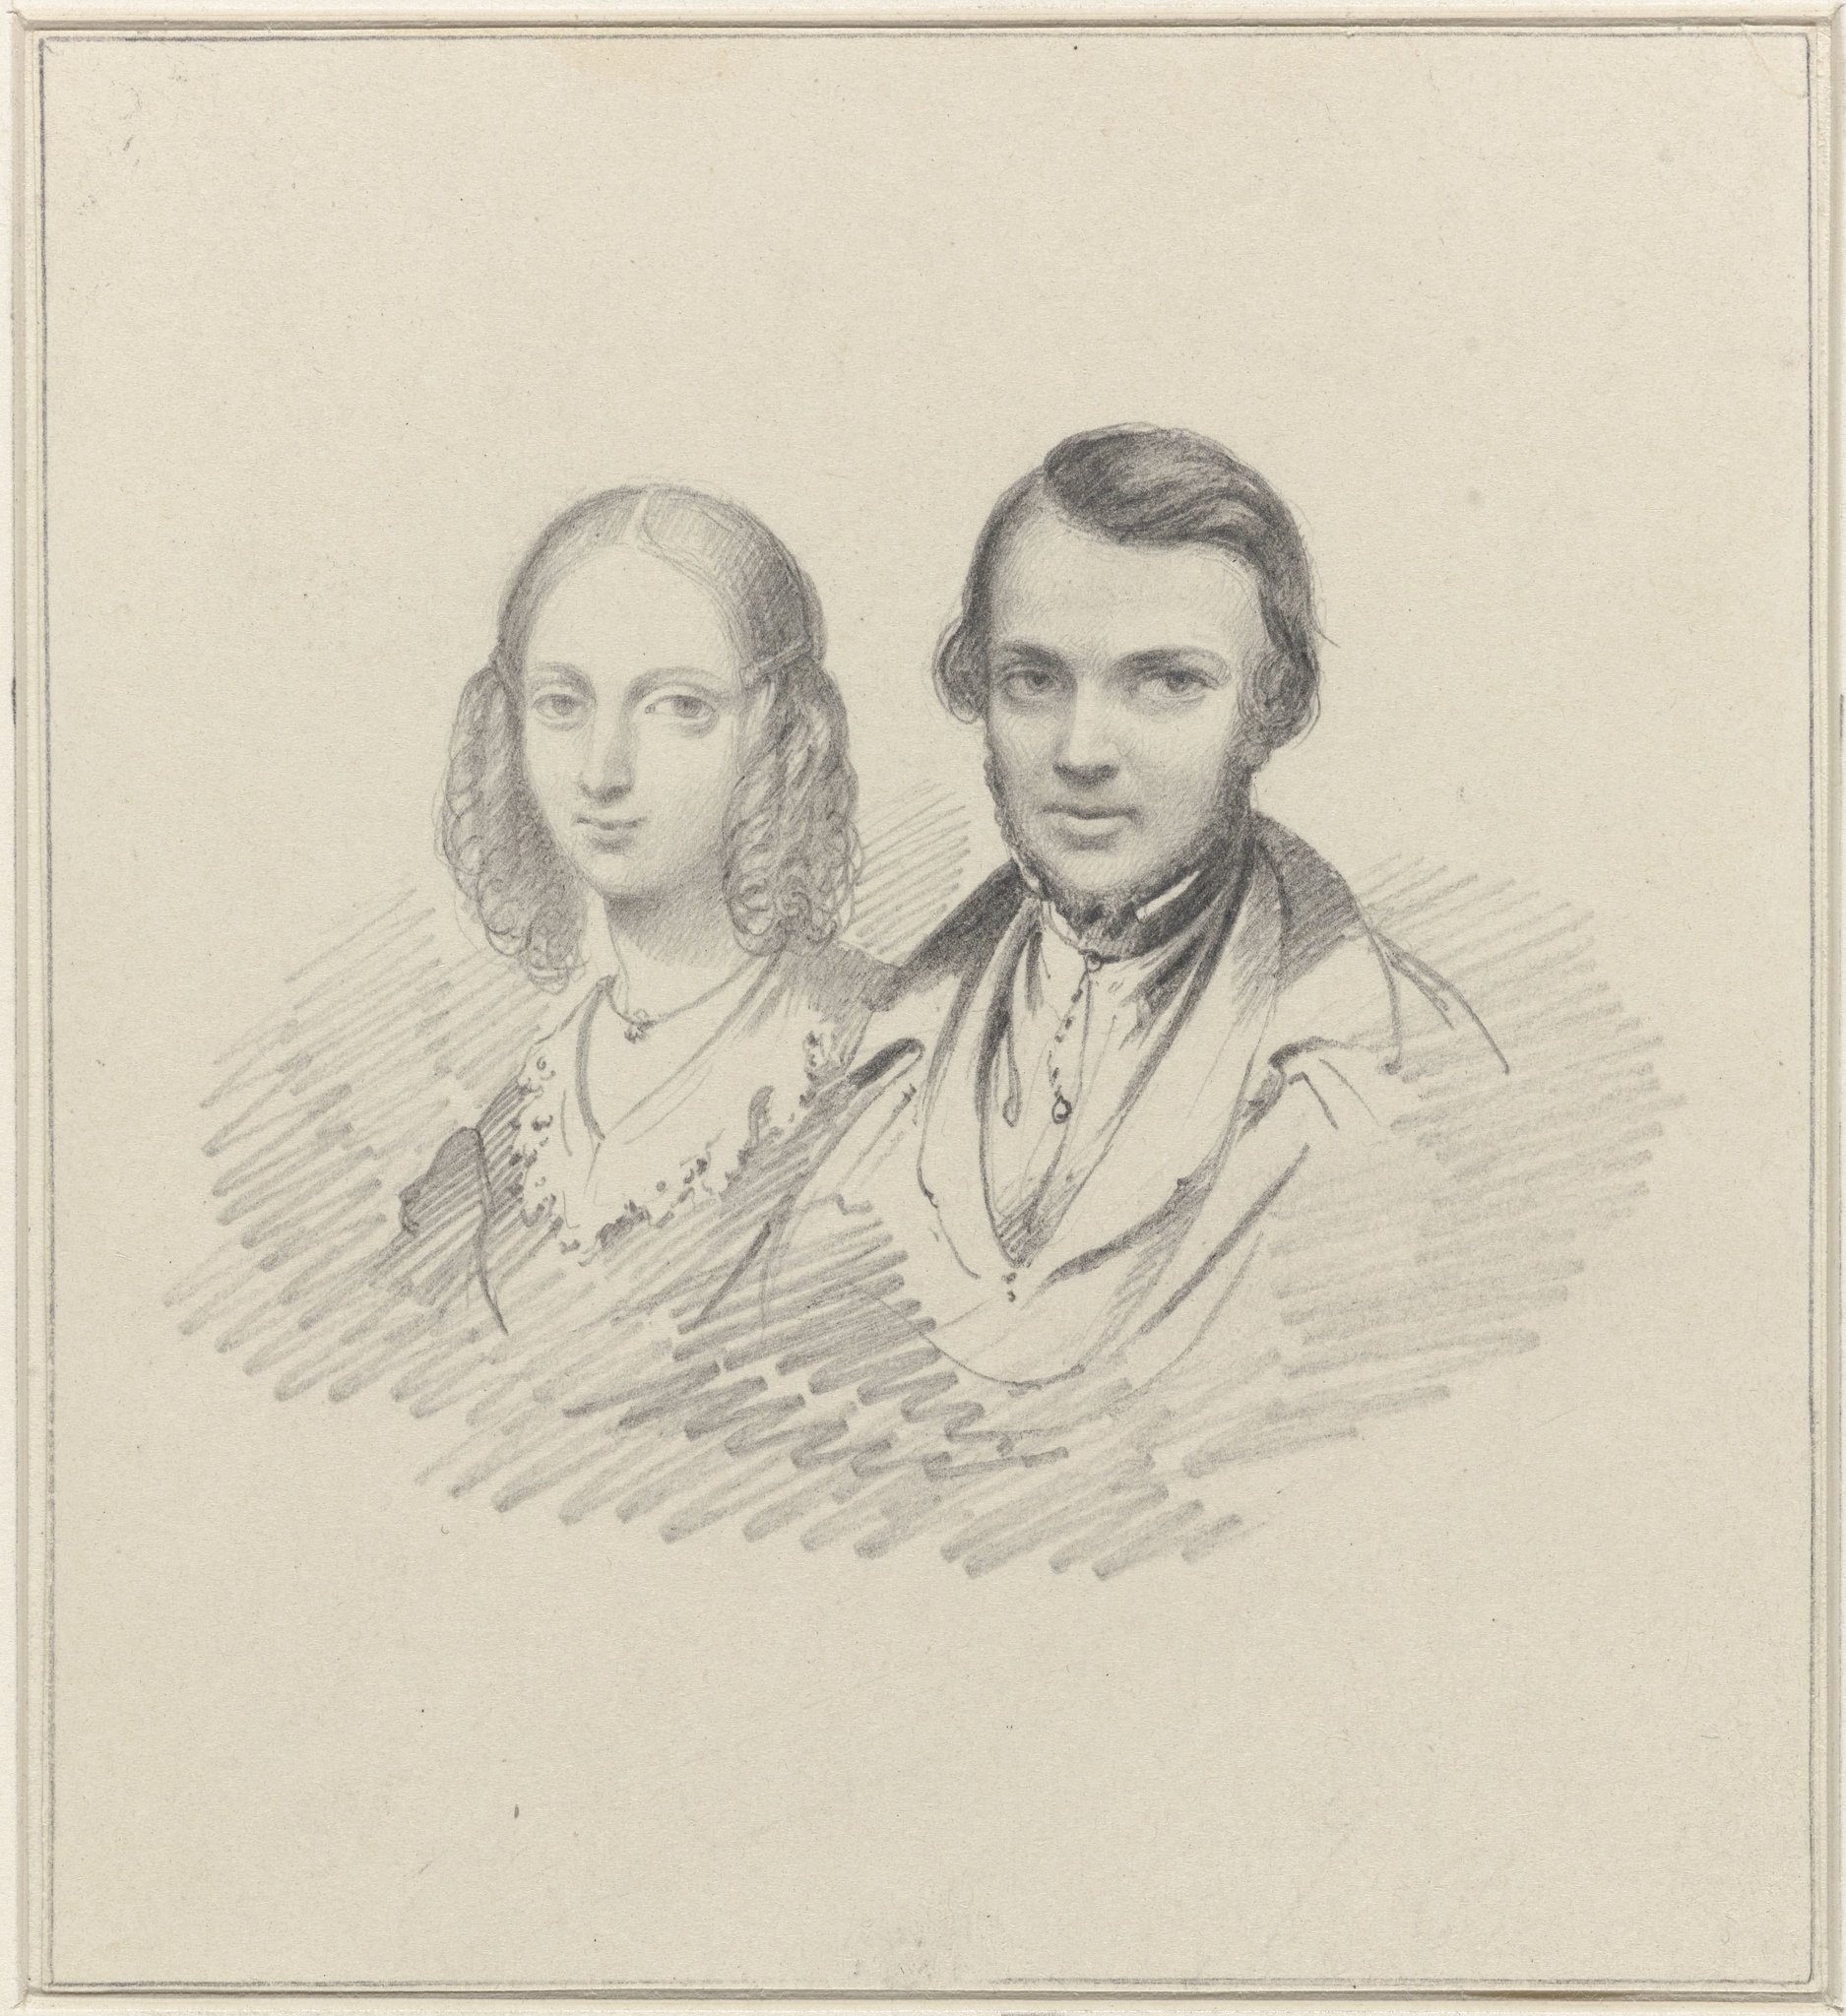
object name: design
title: Dubbelportret van Jean Baptiste van Eijcken en Julie Anne Marie Noël van Eijcken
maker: Anonymous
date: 1841-1842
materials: paper, pencil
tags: brussels, painter, jean baptiste van eycken (1809-1853), julie anne marie noël, historical persons - bb - woman, historical persons, portrait, self-portrait of painter, portrait, self-portrait of artist, portrait, self-portrait of draughtsman